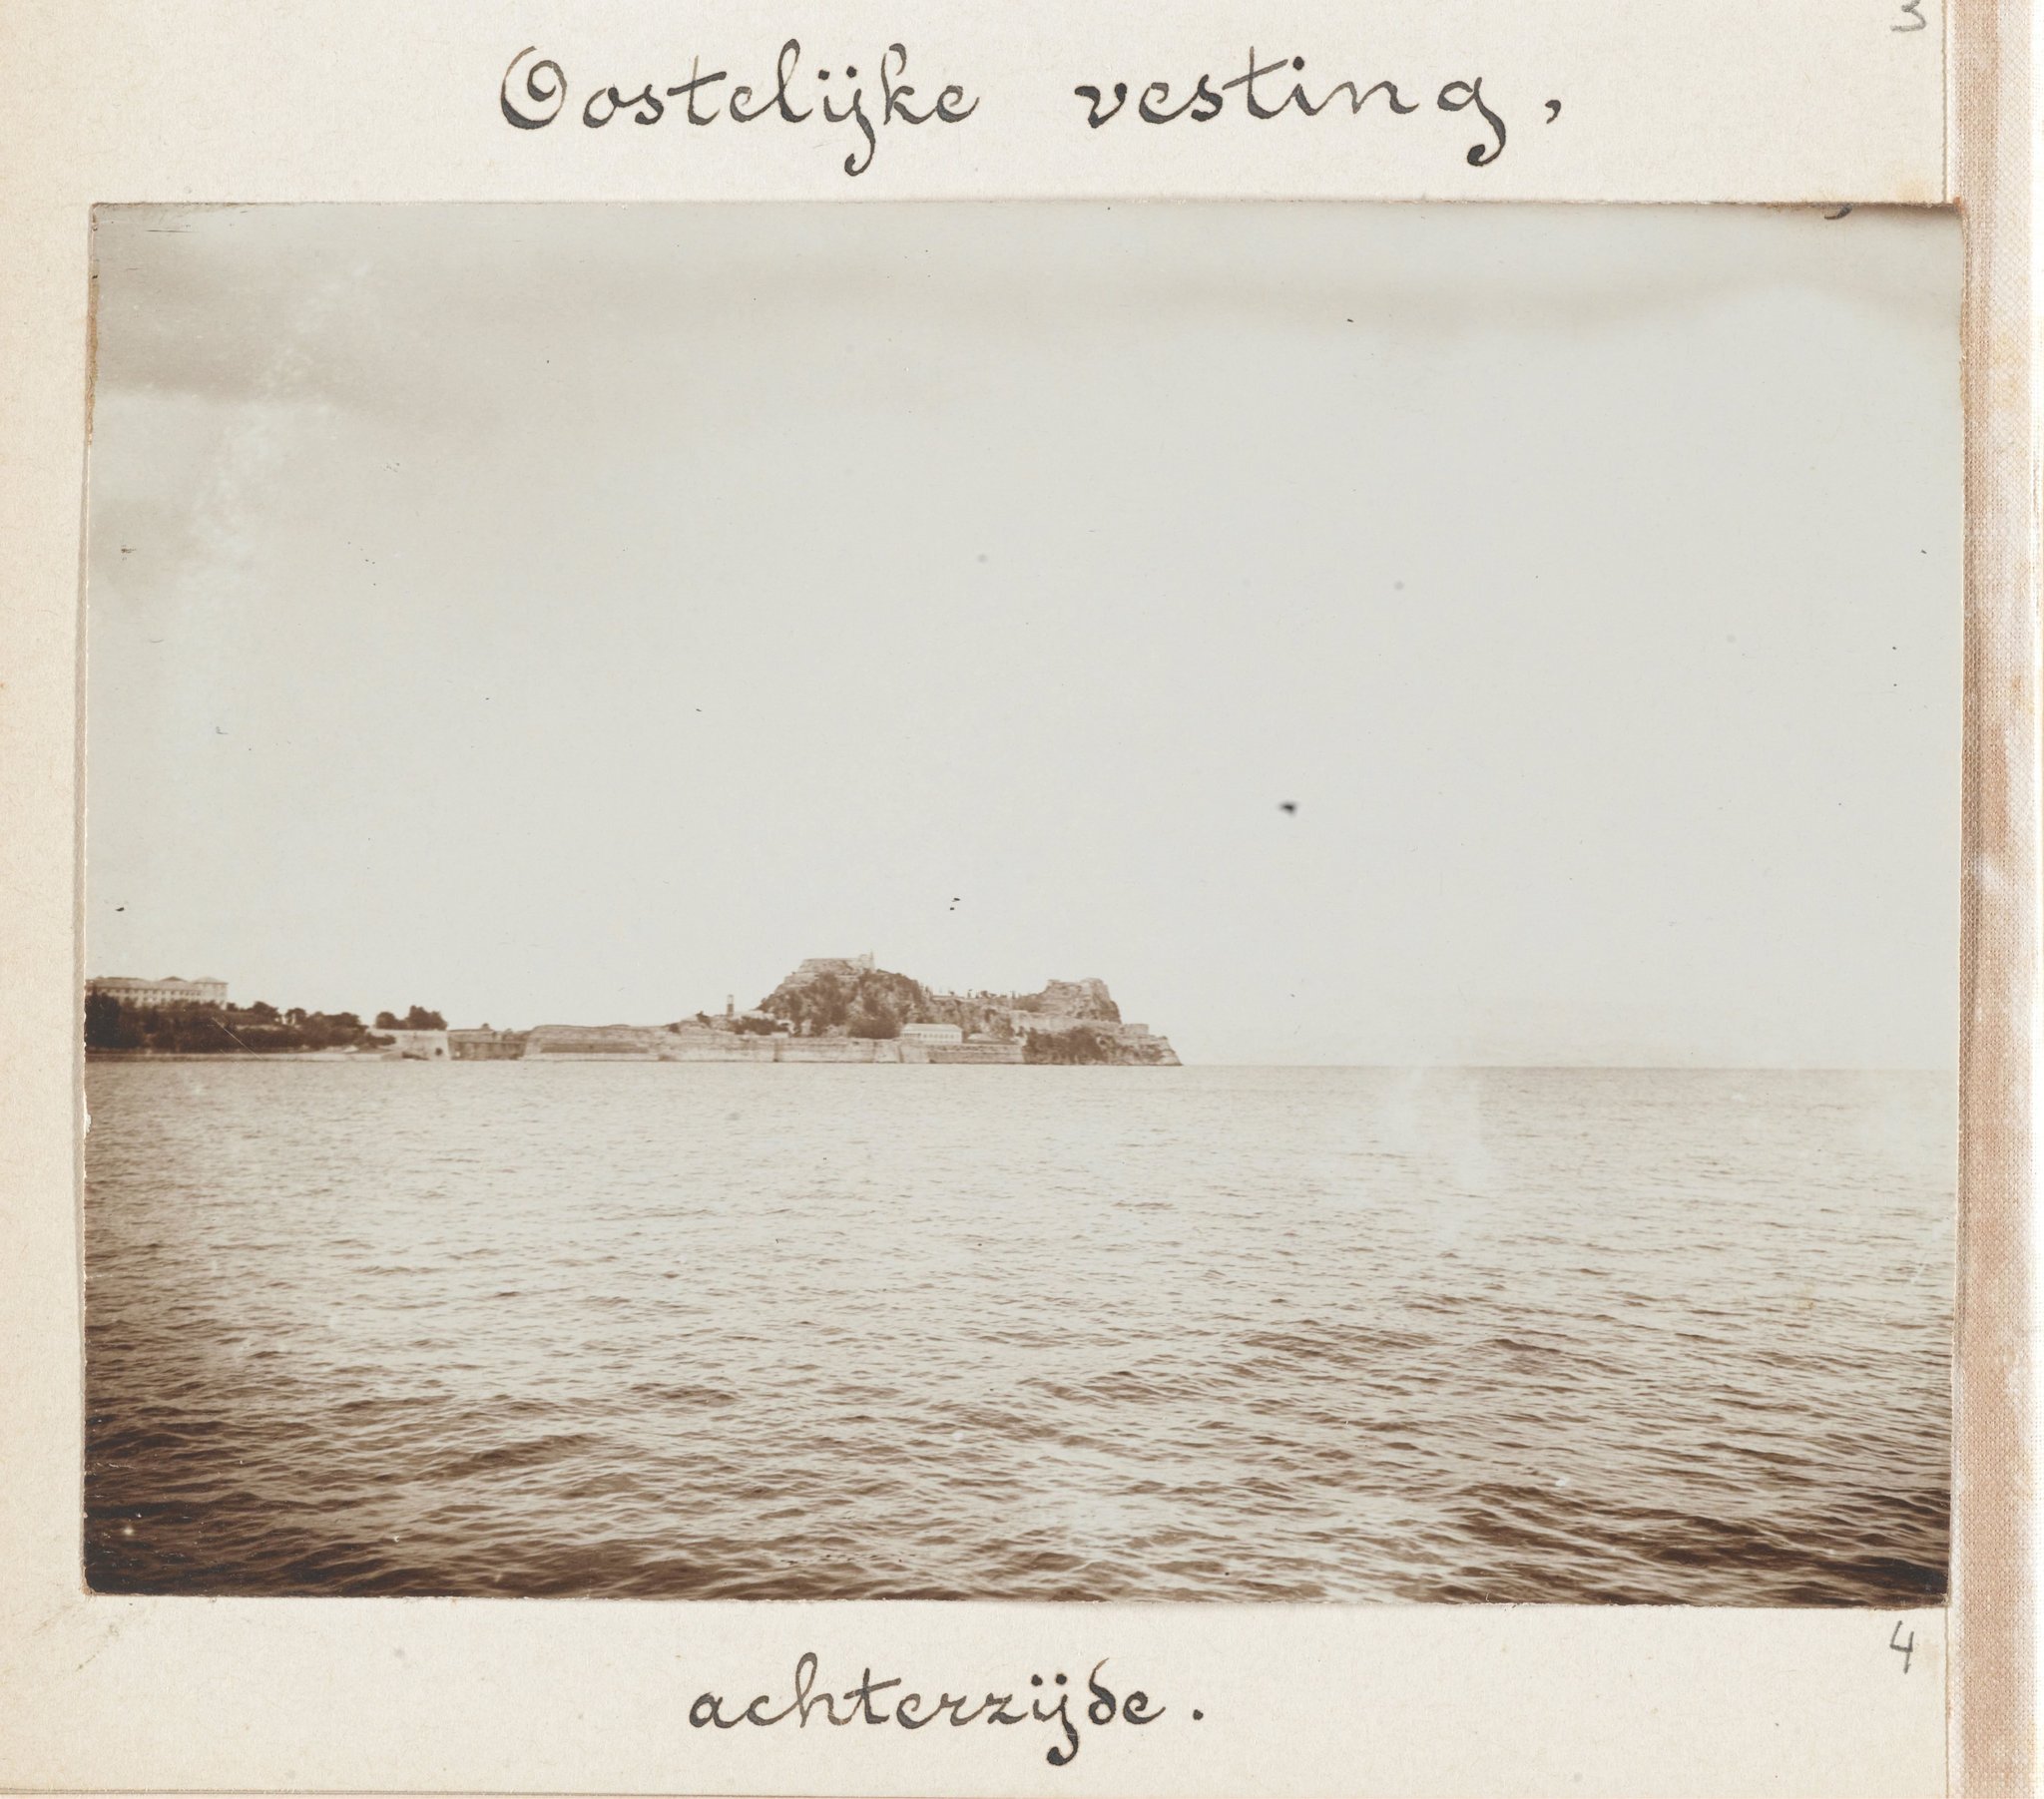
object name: page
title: Oostelijke vesting, achterzijde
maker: johannes lodewijk heldring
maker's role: fotograaf, predikant, schrijver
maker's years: 1852-1923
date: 1898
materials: paper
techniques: collodion silver print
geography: corfu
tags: fortress